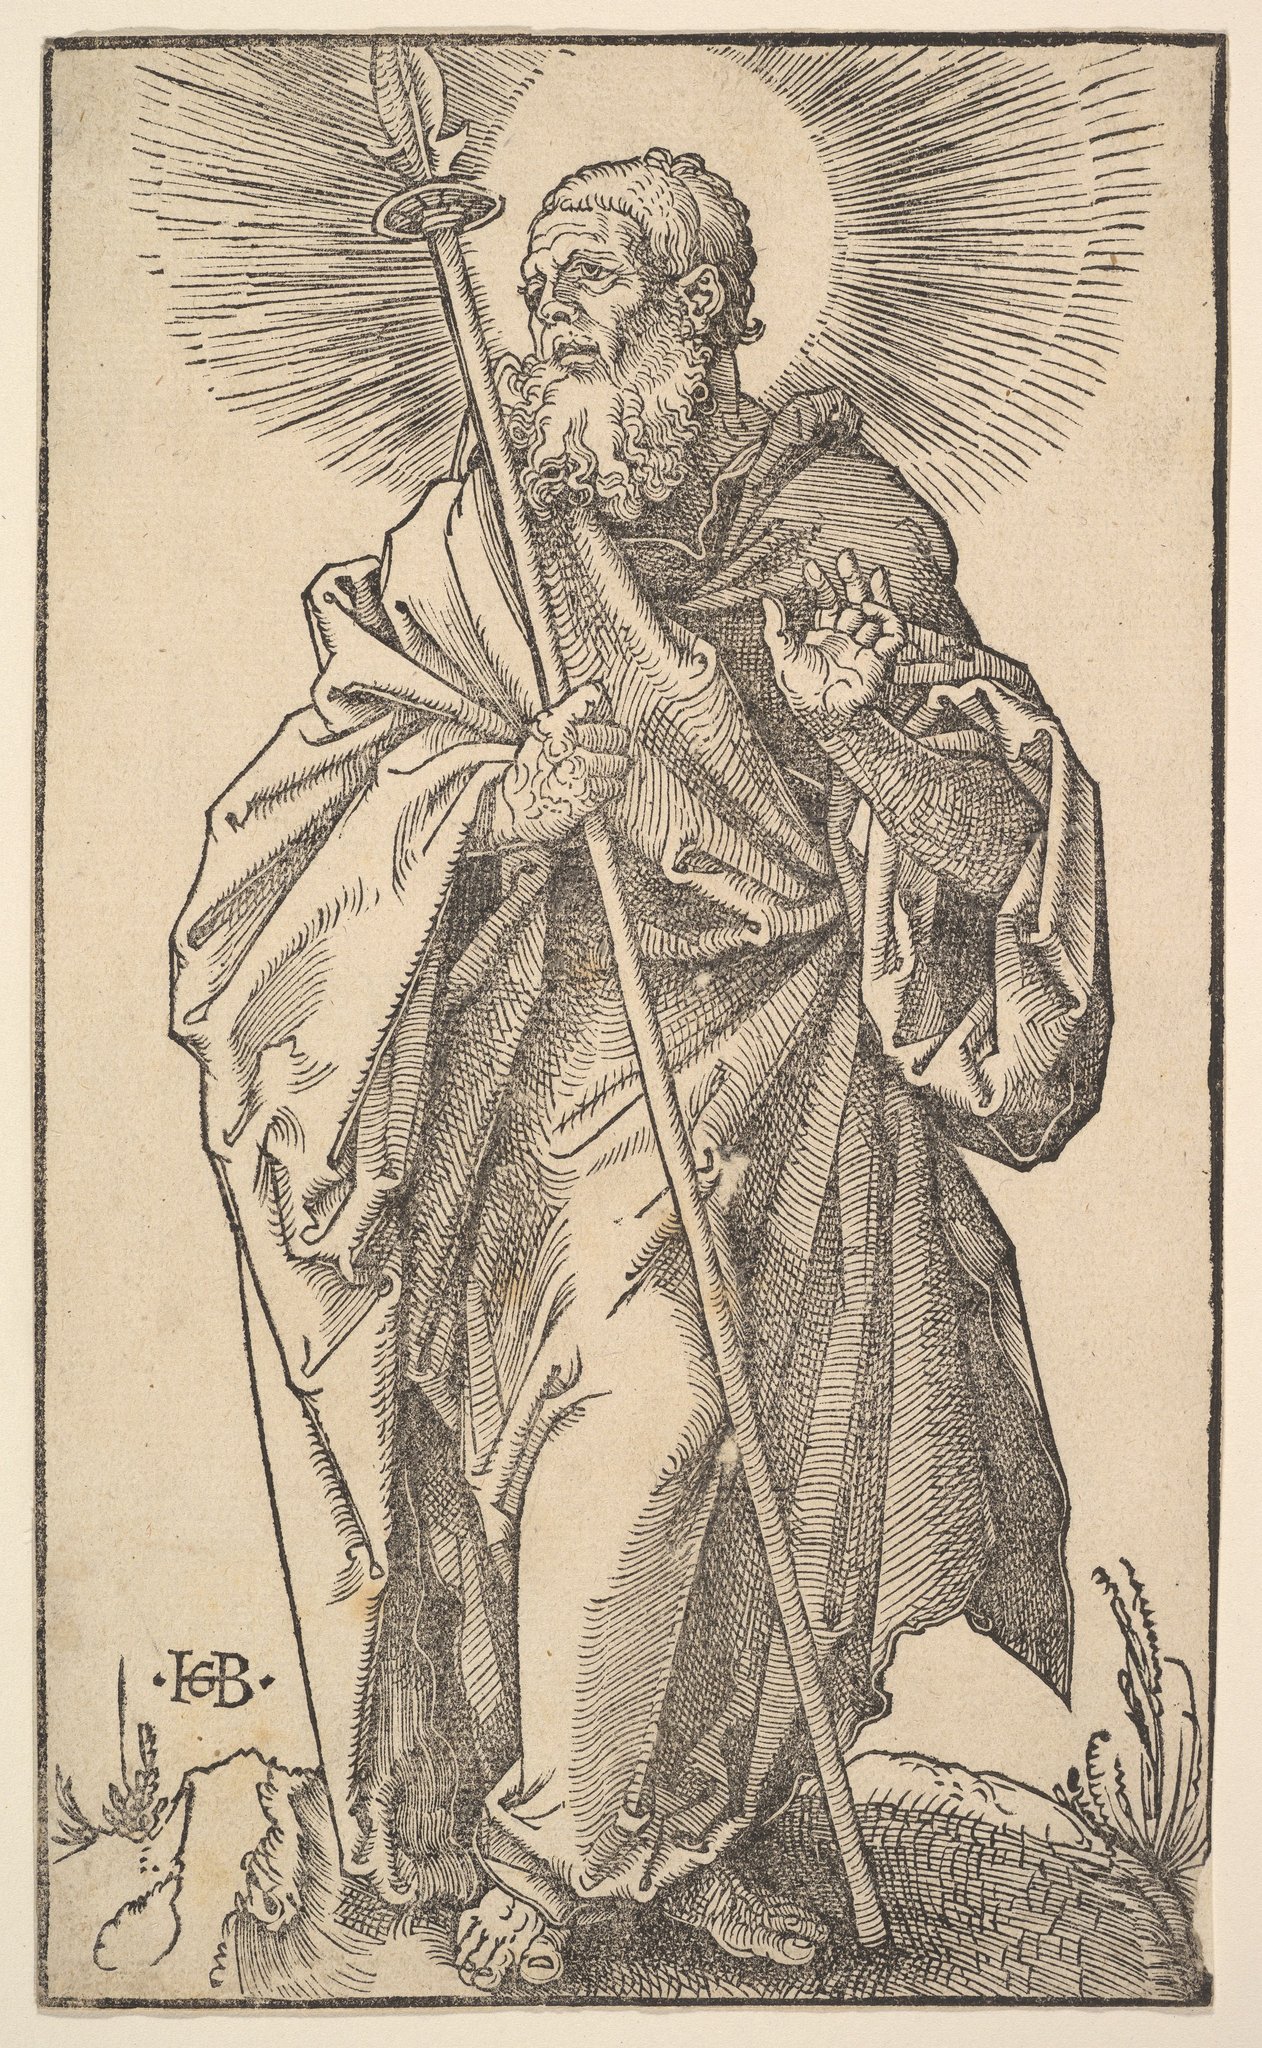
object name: print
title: St. Thomas, from "Christ and the Apostles"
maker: hans baldung (called hans baldung grien)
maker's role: artist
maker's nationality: german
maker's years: 1484-1545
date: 1519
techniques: woodcut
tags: men,saints